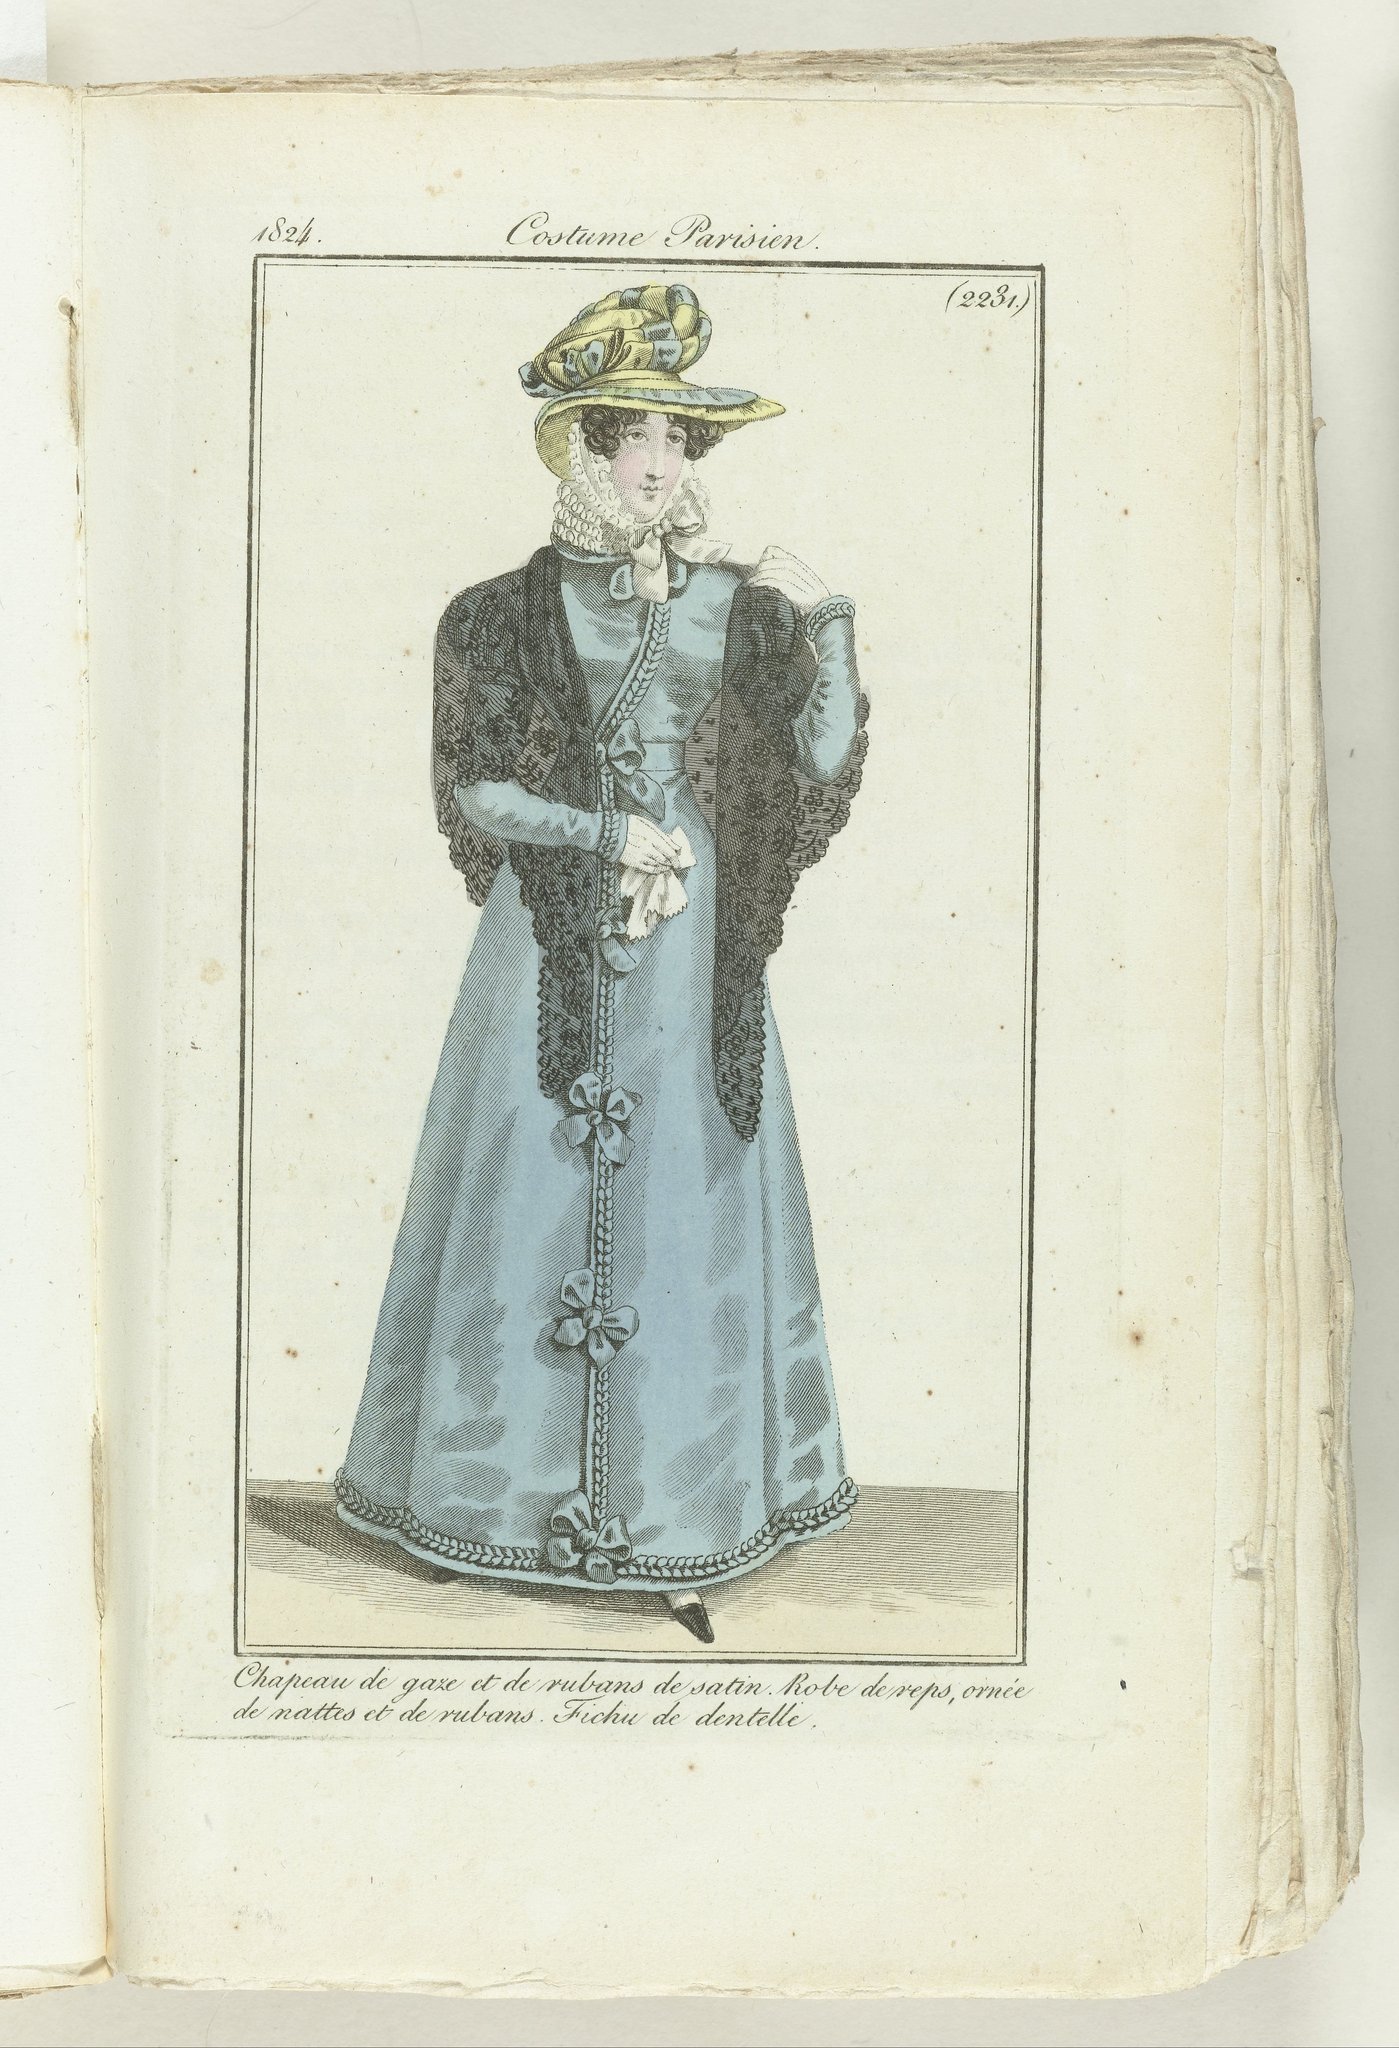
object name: fashion print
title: Journal des Dames et des Modes 1824, Costume Parisien (2231)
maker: Anonymous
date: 1824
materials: paper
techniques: etching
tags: fashion plates, clothes, costume (+ women's clothes)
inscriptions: date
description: Prent uit het tijdschrift Journal des Dames et des Modes, 1824.